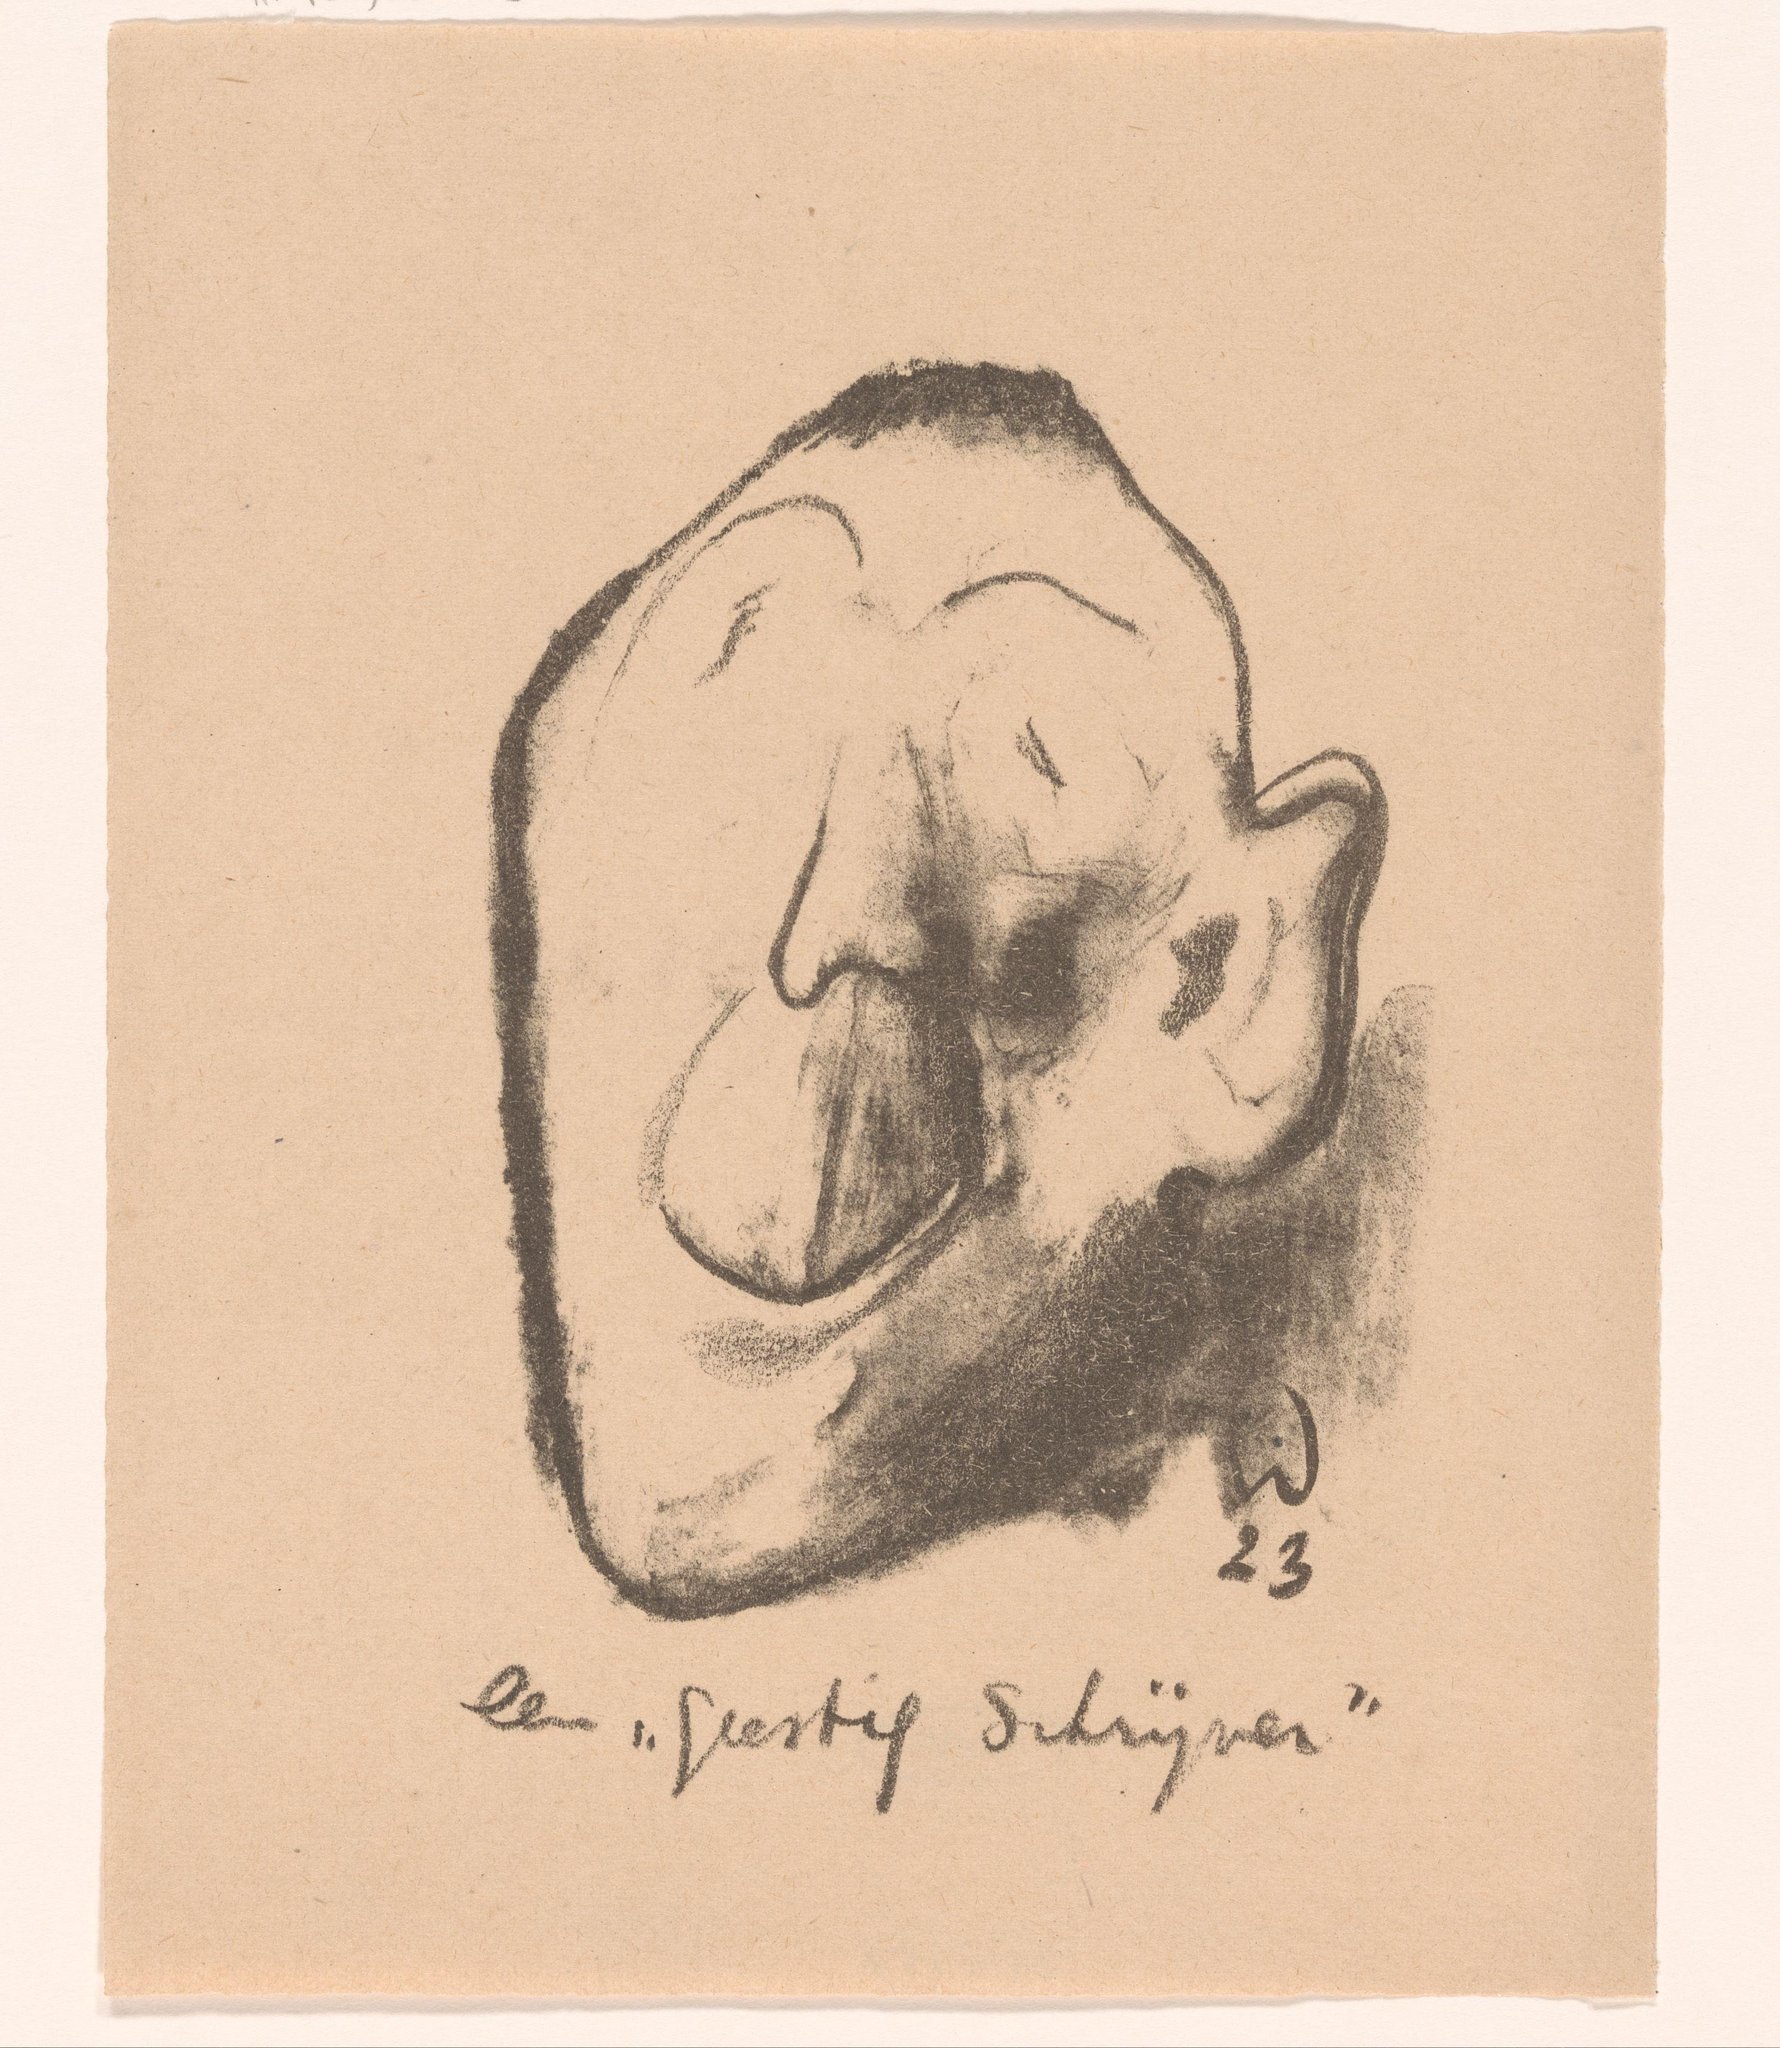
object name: print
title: Idealisten II en verdere Kanttekeningen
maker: erich wichmann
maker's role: print maker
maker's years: 1890-1929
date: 1923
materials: paper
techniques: lithograph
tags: caricatures (human types), writer, poet, author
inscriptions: collector's mark: Lugt 2228